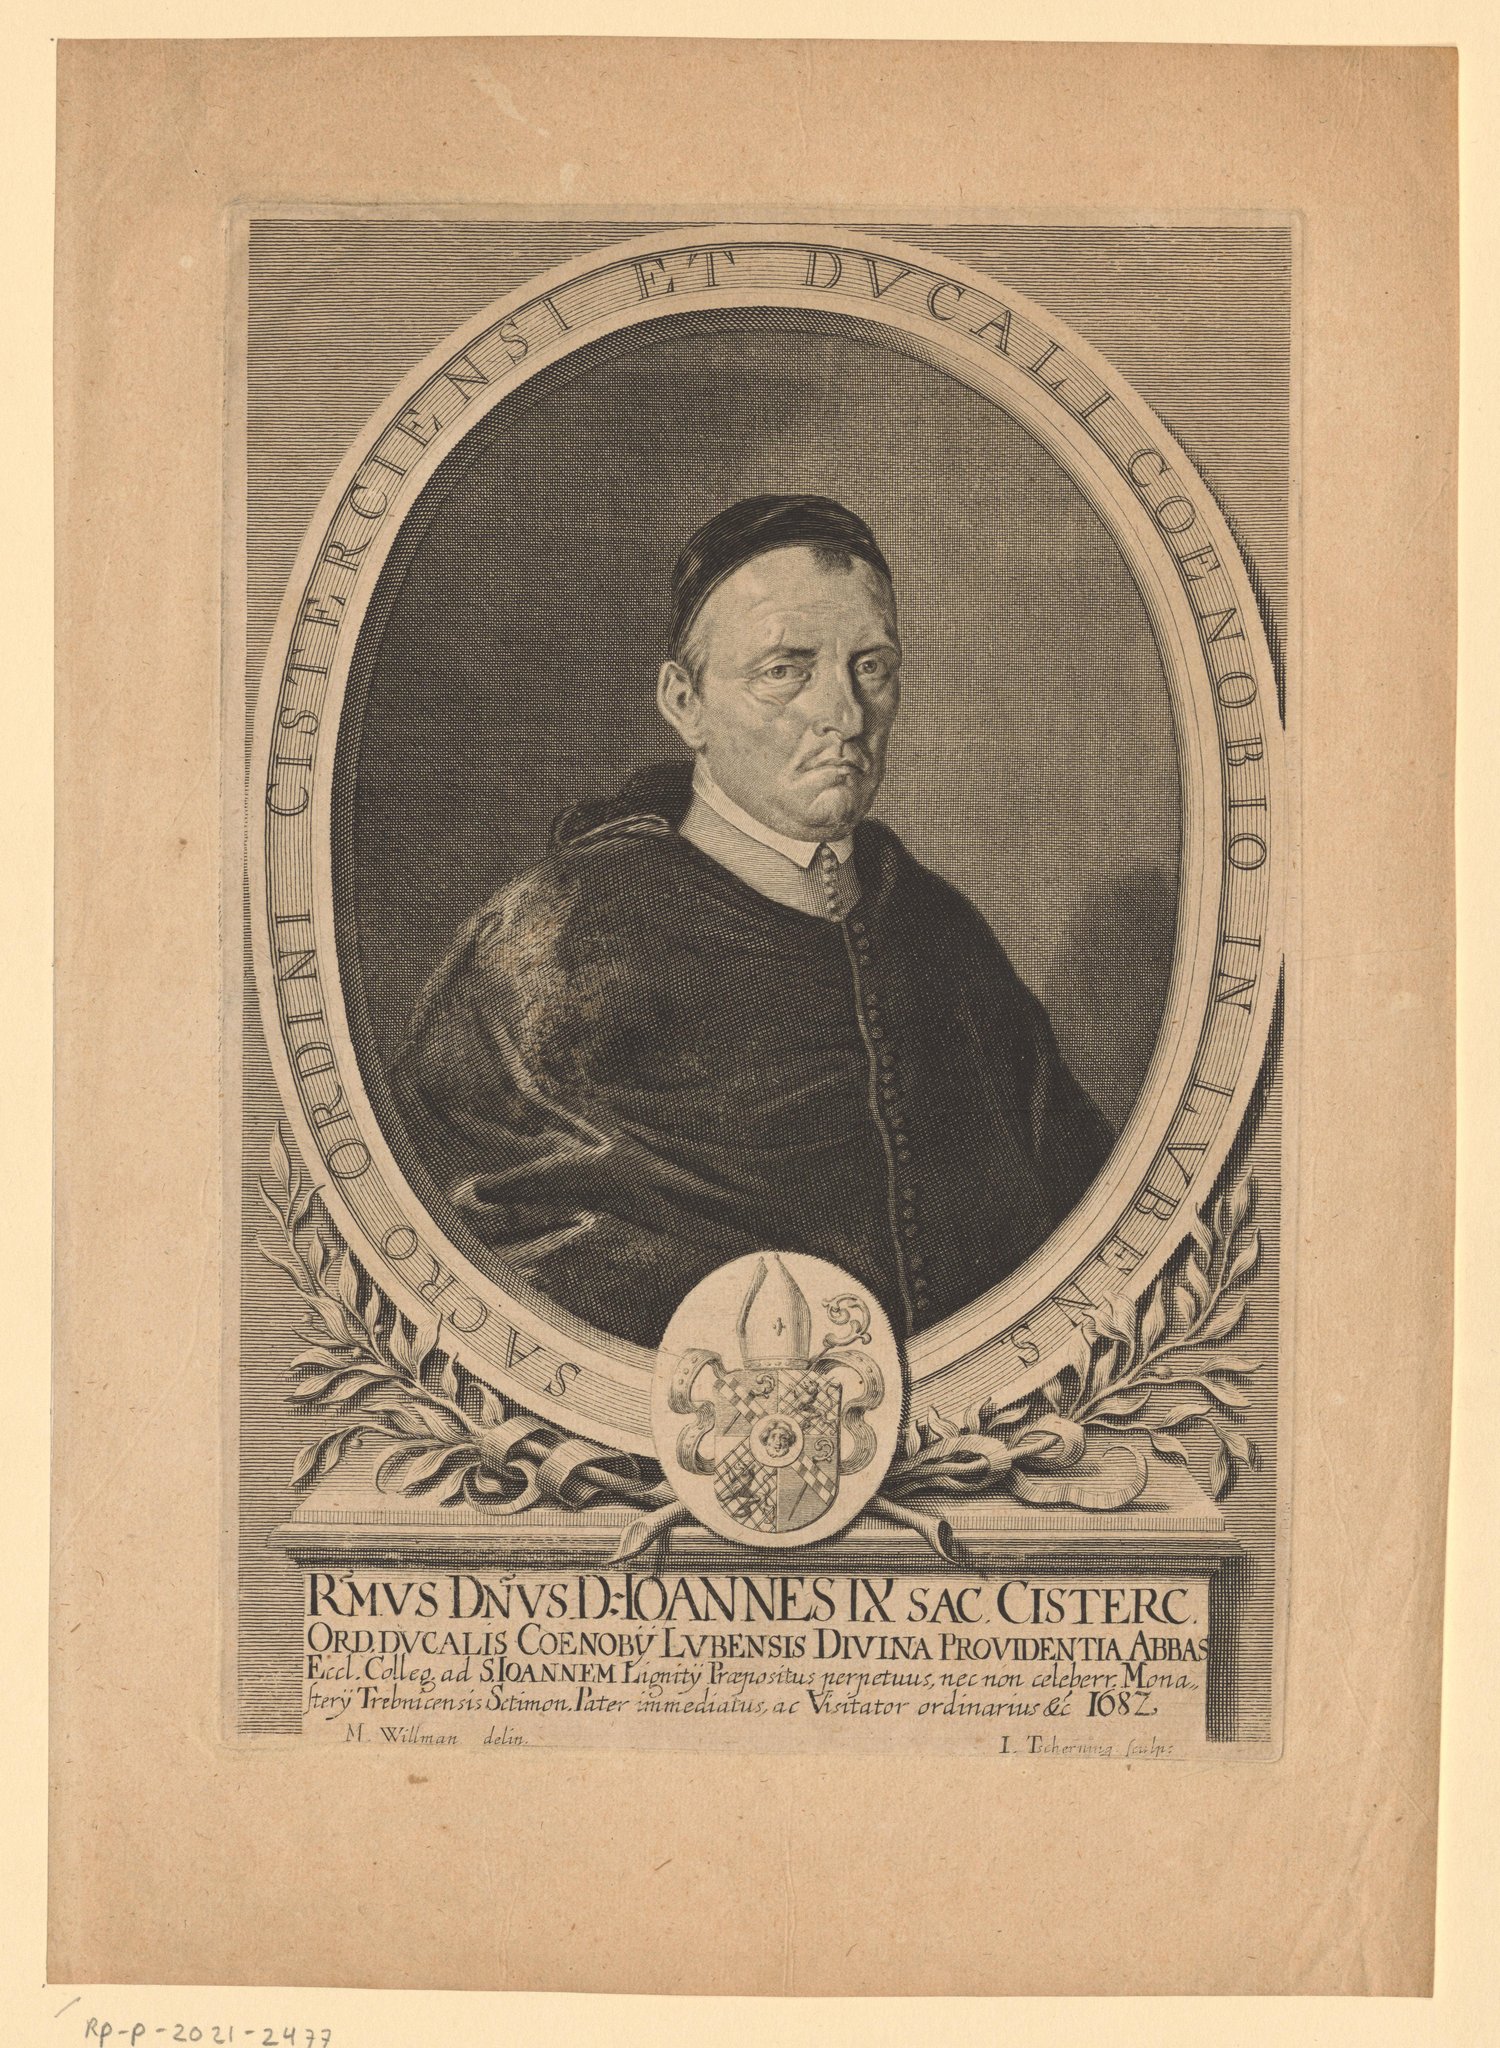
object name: print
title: Portret van Johannes IX van Leubus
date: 1682-1732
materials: paper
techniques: engraving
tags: ornament ~ medallion, historical persons, armorial bearing, heraldry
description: Met onderschrift in het Latijn en tekst in het Latijn rondom het portret.